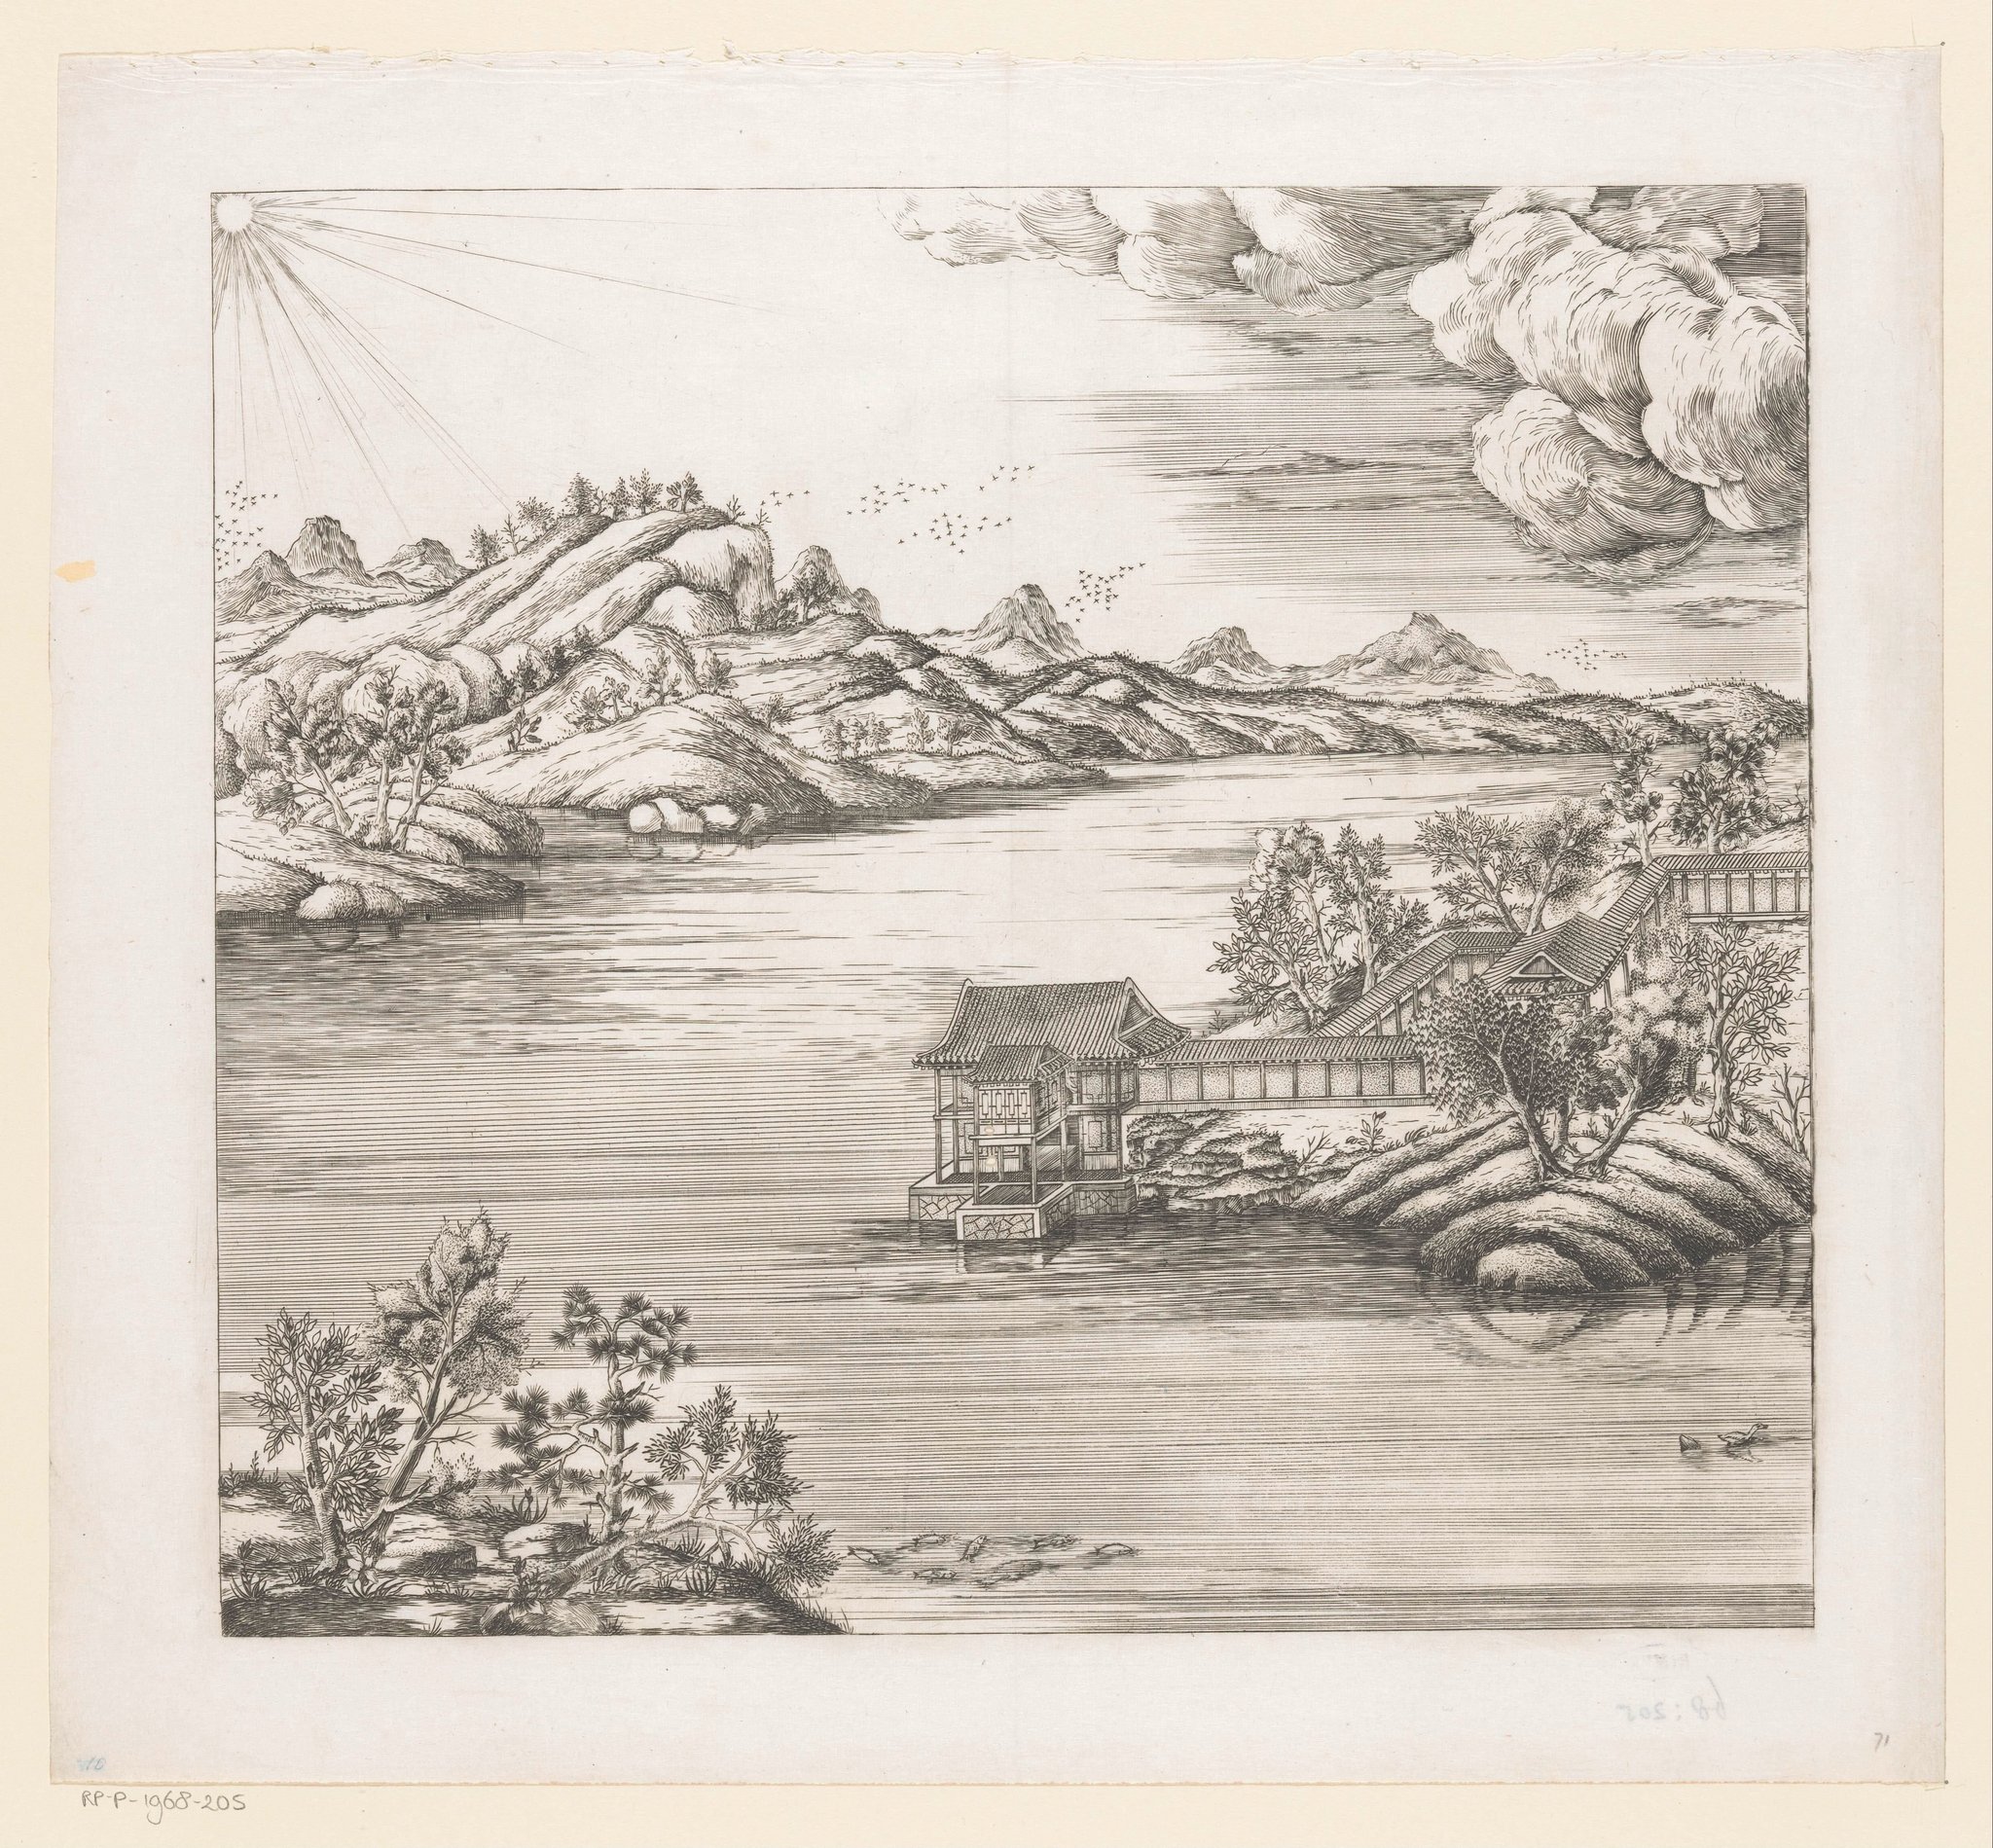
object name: print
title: ‘Morning Mist by the Western Ridge’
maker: matteo ripa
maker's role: priest, print maker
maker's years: 1682-1746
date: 1712-1714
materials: paper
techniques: engraving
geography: china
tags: city-view, and landscape with man-made constructions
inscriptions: collector's mark: Lugt 2228, collector's mark: ‘GW’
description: While experimenting with copperplate engraving, Ripa faced various challenges. These included sourcing suitable raw materials for the ink, mastering the printing press, and adapting the Chinese imagery of the woodcuts into the European medium of engraving. Here, he blended his European perspective into the Chinese model in his portrayal of the sun and clouds.